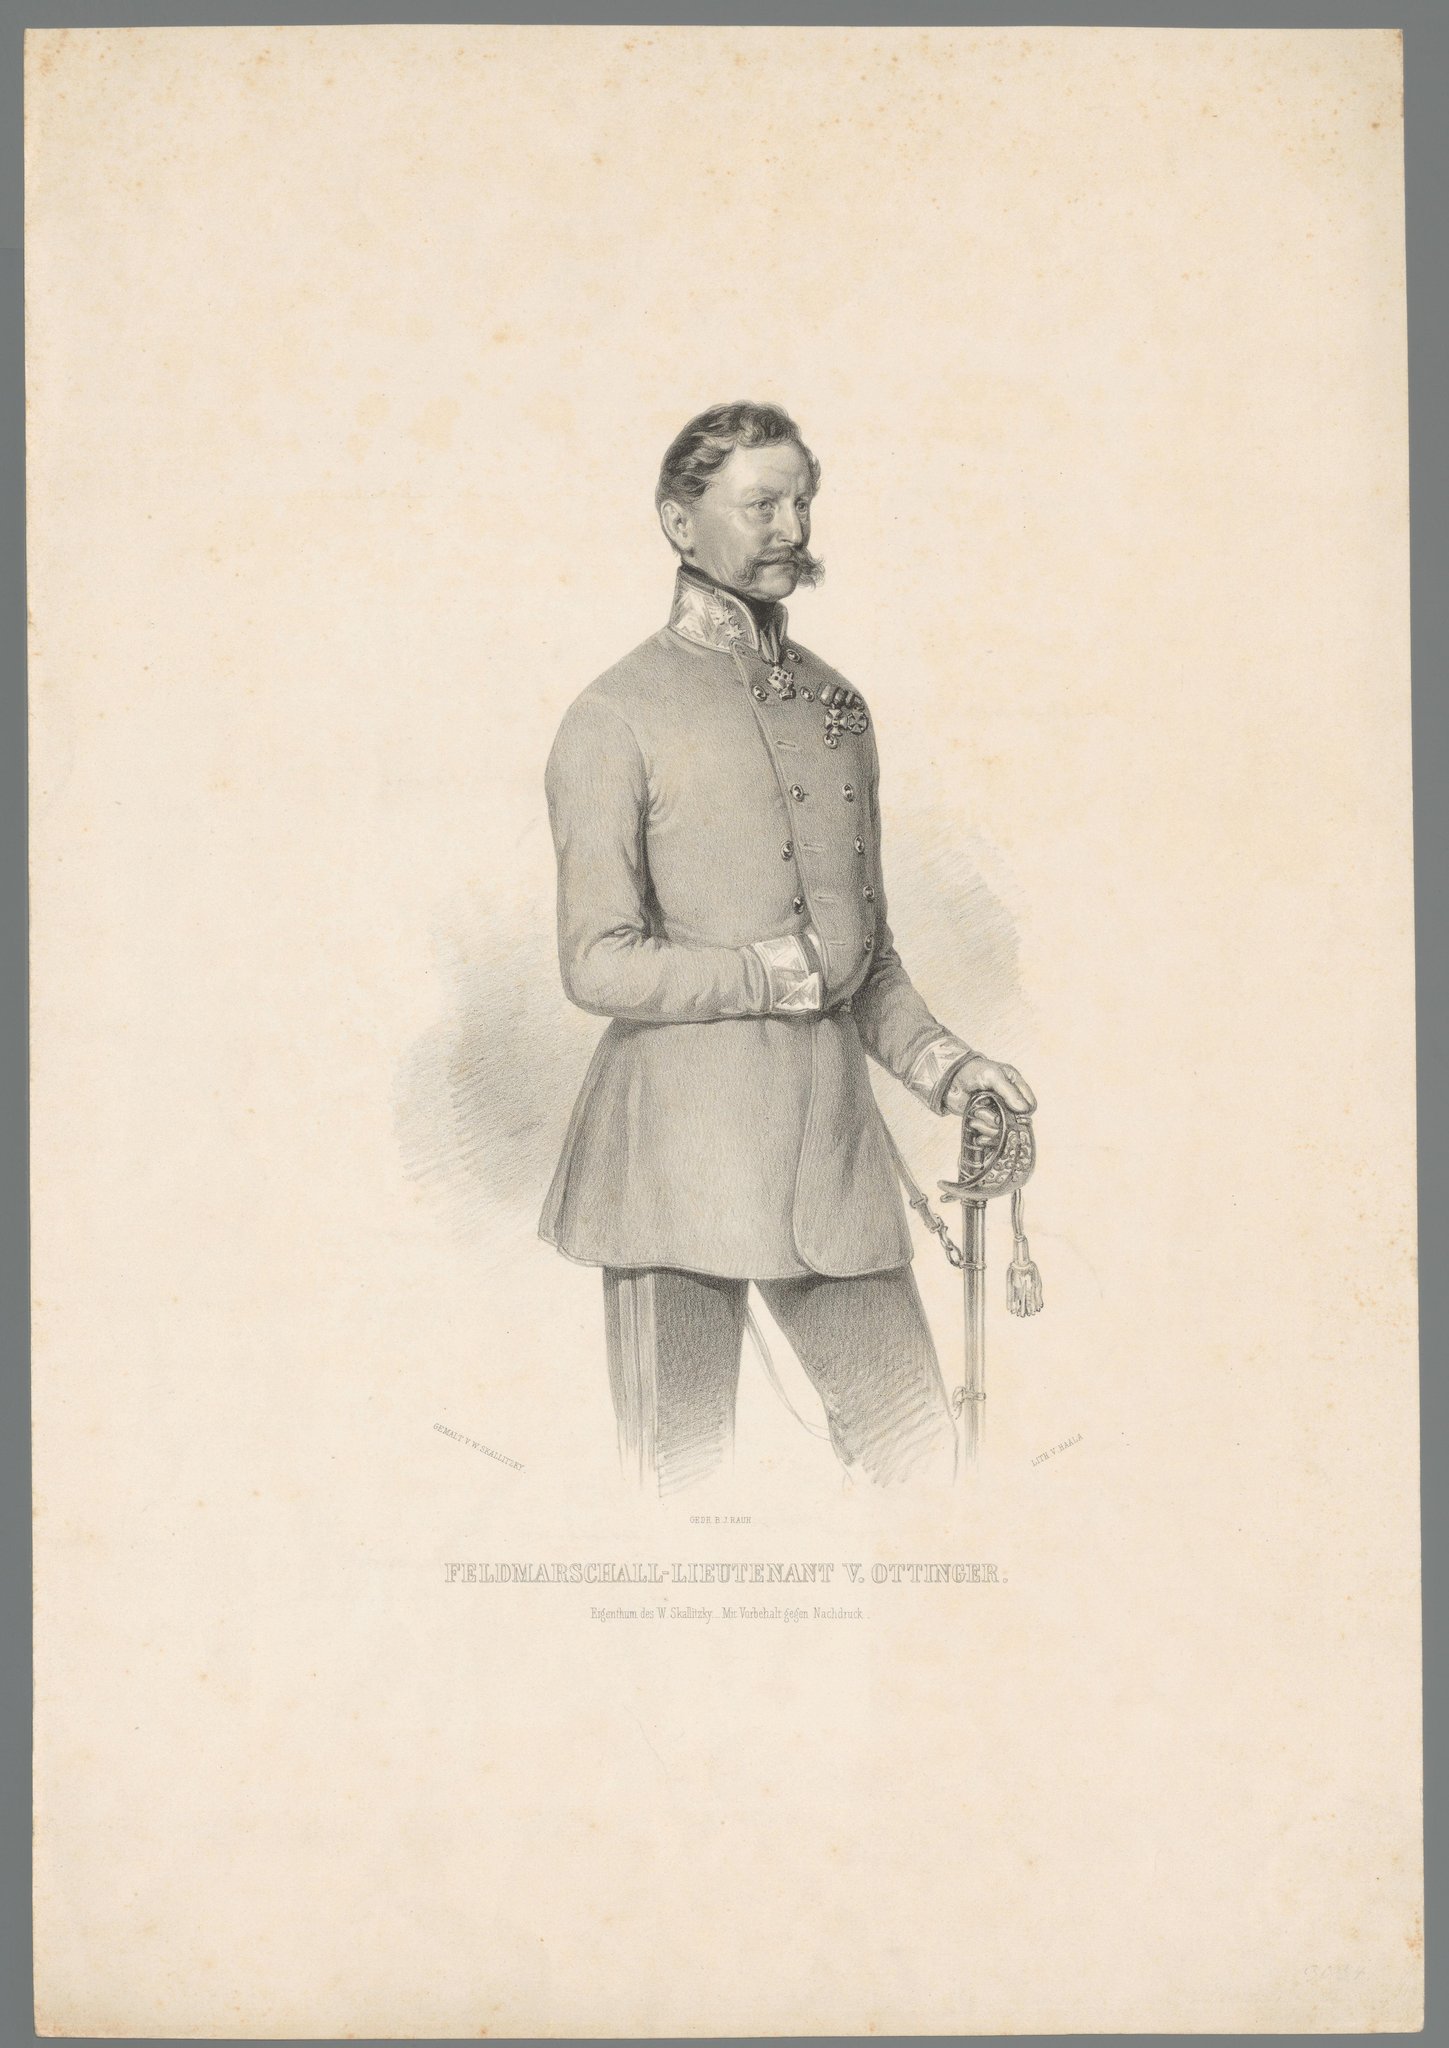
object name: print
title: Feldmarschall-Lieutenant v. Ottinger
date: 1820-1867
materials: paper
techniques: lithograph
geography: vienna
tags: adult man, historical persons, hacking and thrusting weapons: sword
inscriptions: collector's mark: Lugt 2228